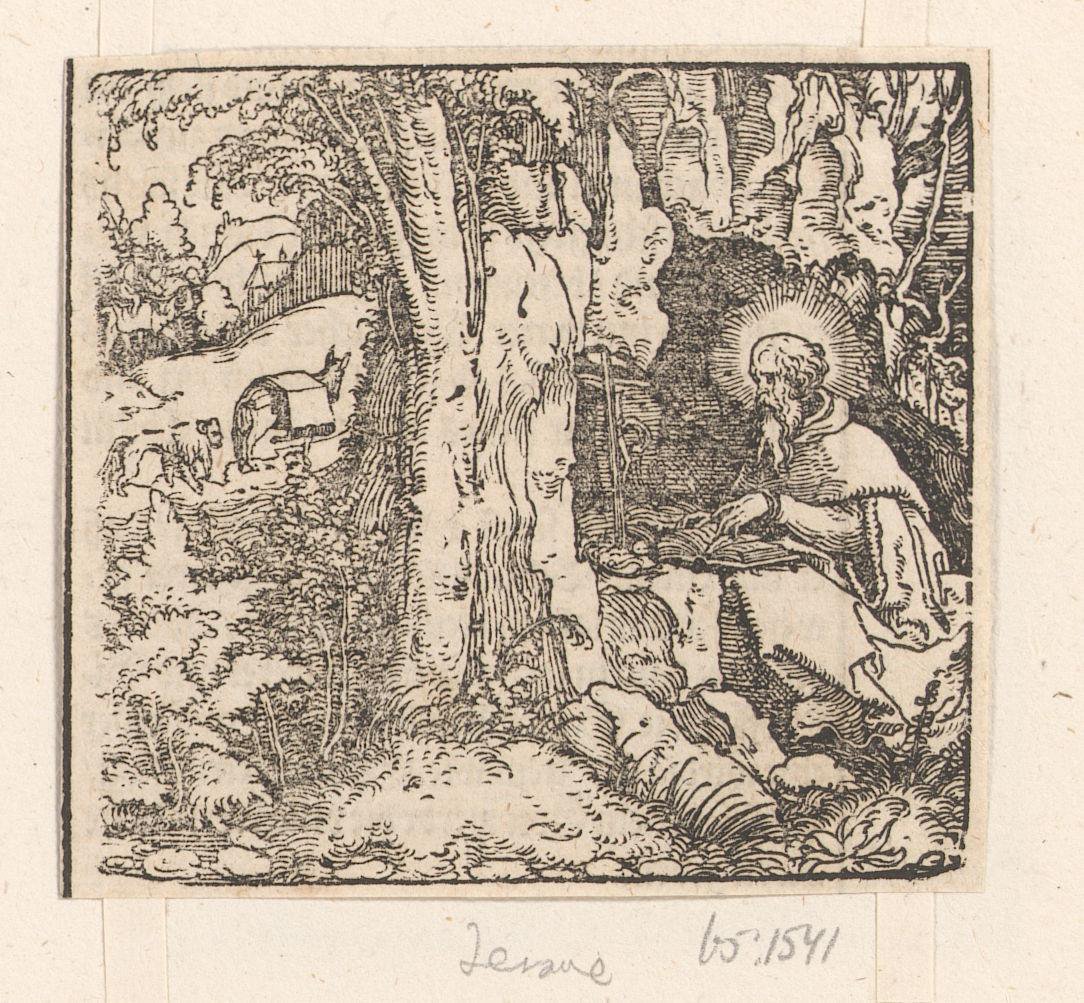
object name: print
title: Heilige Hiëronymus in de wildernis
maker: Anonymous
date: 1500-1536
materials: paper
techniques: woodcut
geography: germany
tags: st. jerome as hermit in a landscape, reading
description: De Heilige Hiëronymus zit in een landschap te bidden bij een crucifix. Prent maakt deel uit van een album.